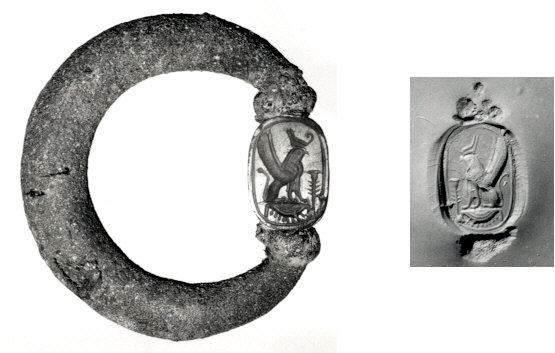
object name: ring with scarab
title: Silver swivel ring with sard scarab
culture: cypriot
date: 800-668 BCE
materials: silver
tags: sphinx,scarabs